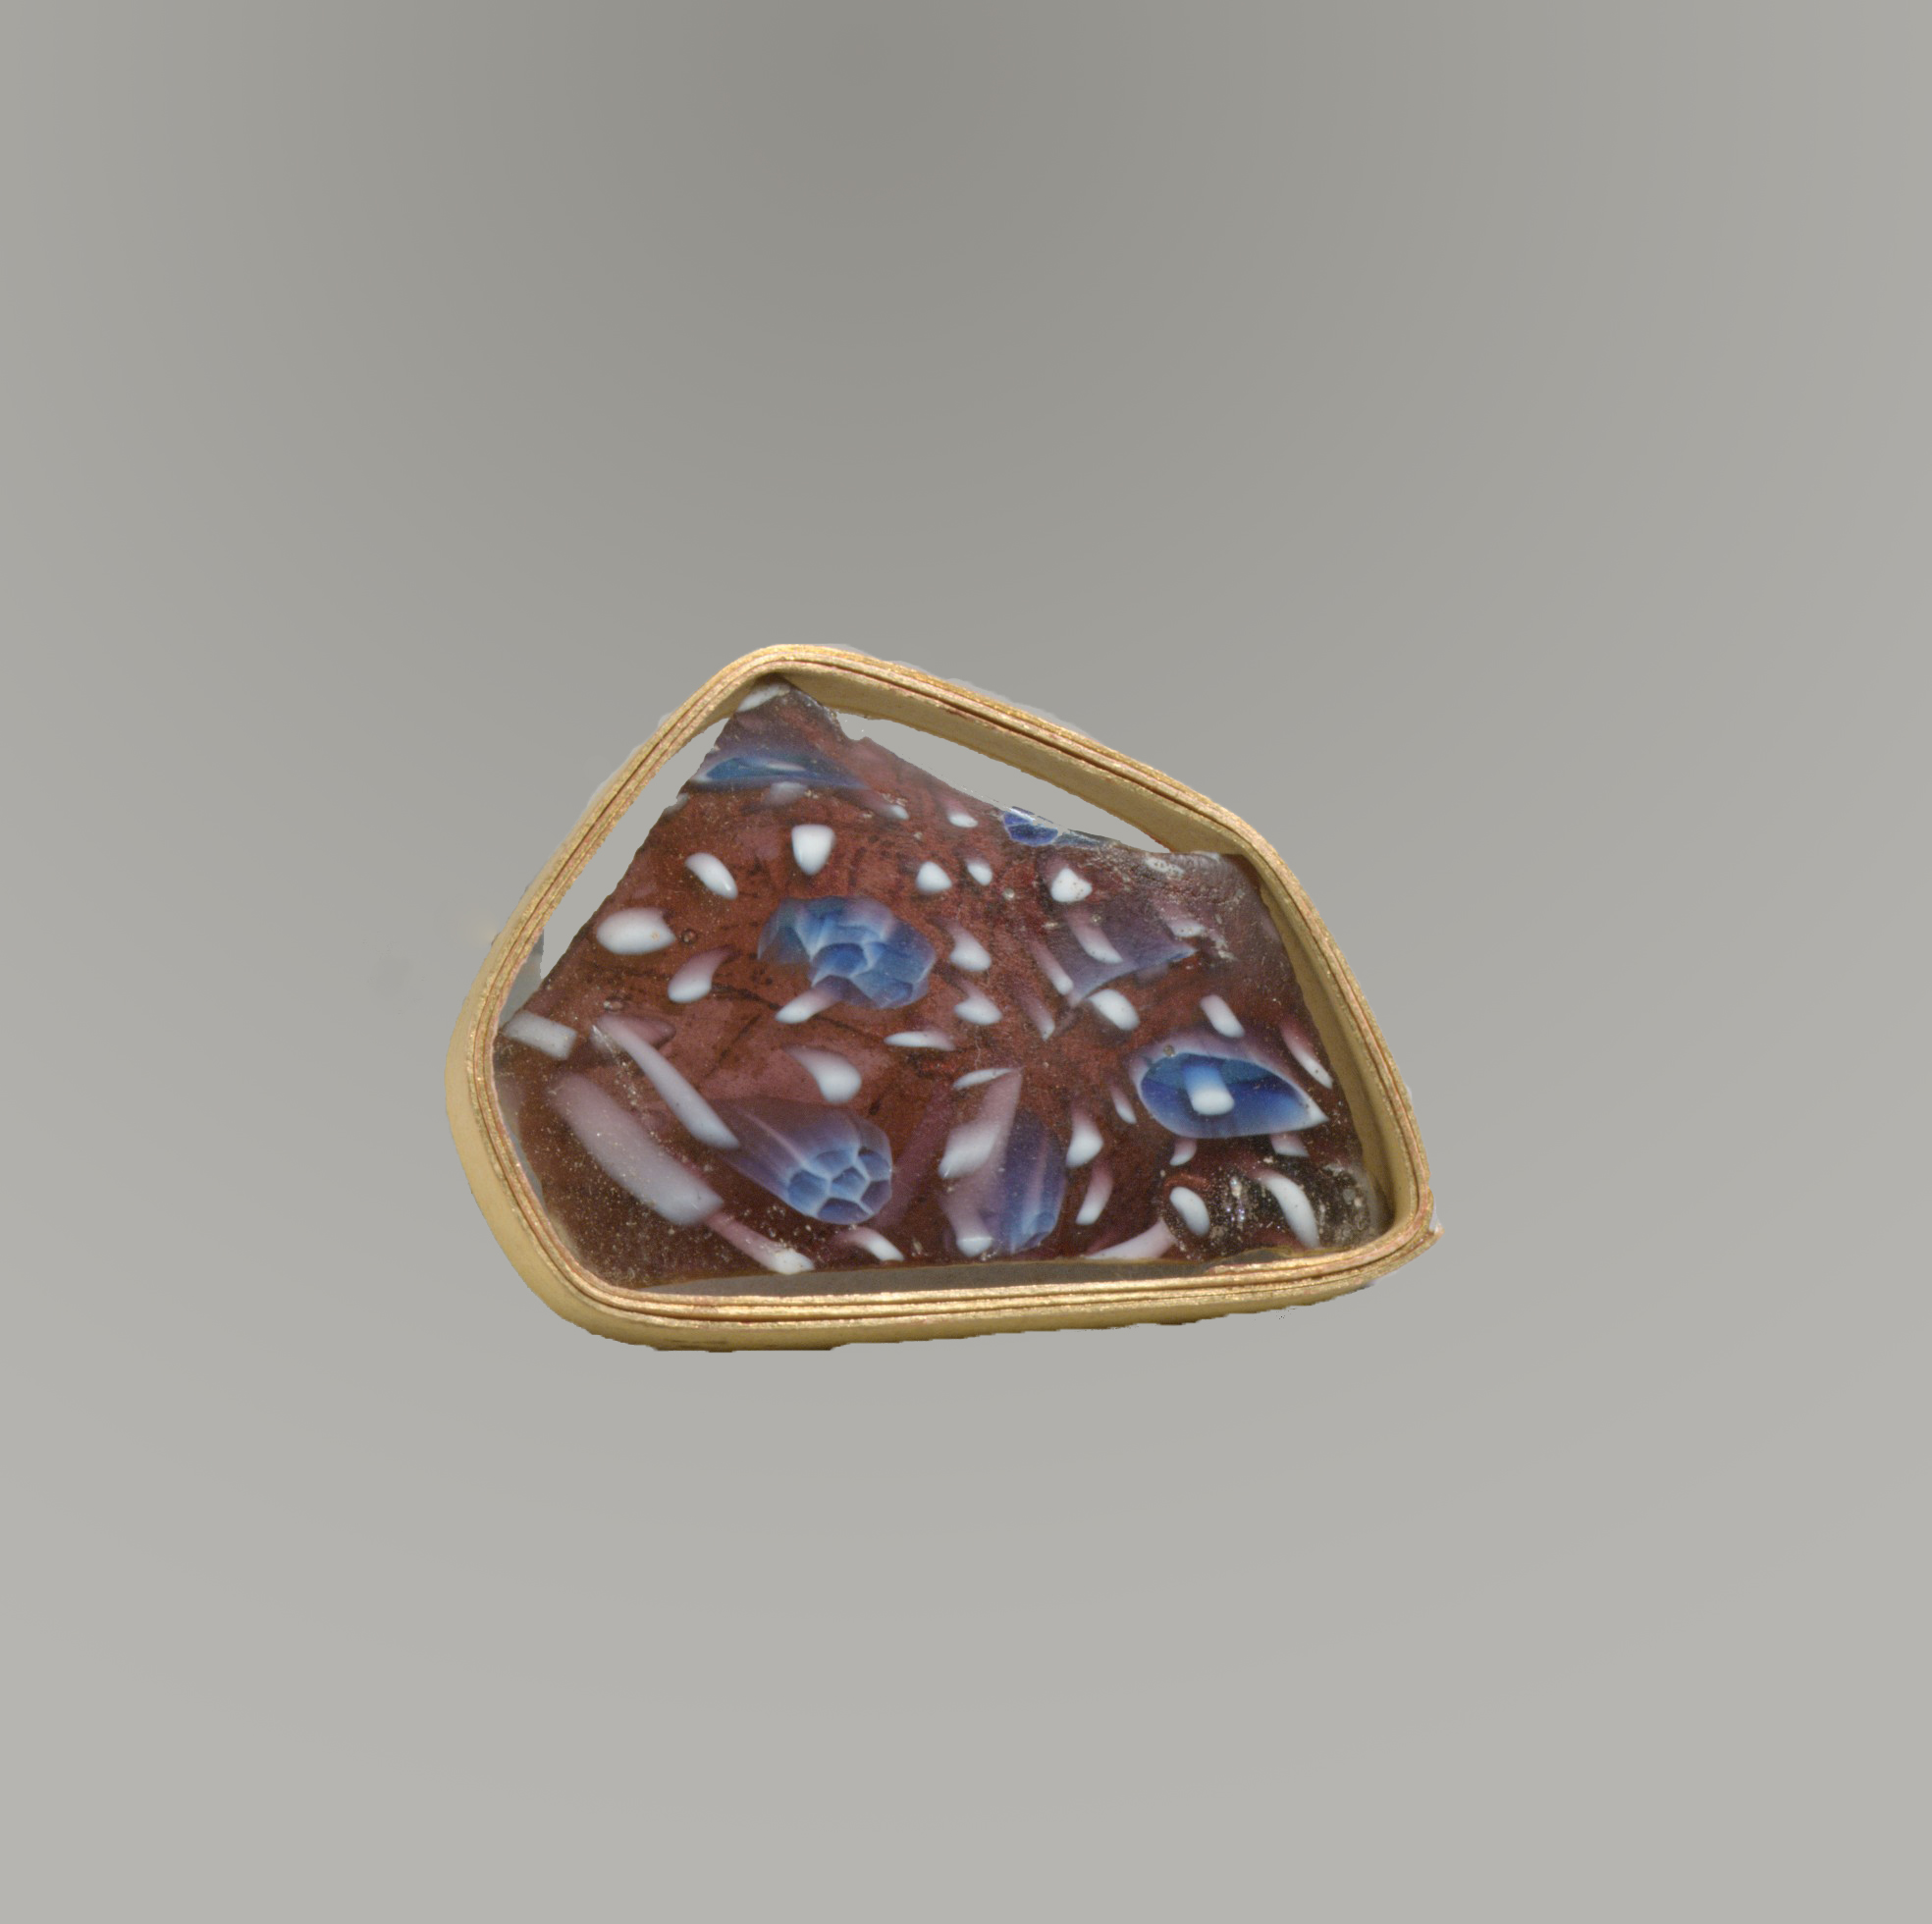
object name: fragment, mosaic bowl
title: Glass mosaic bowl fragment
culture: roman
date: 34 BCE-33 CE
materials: glass